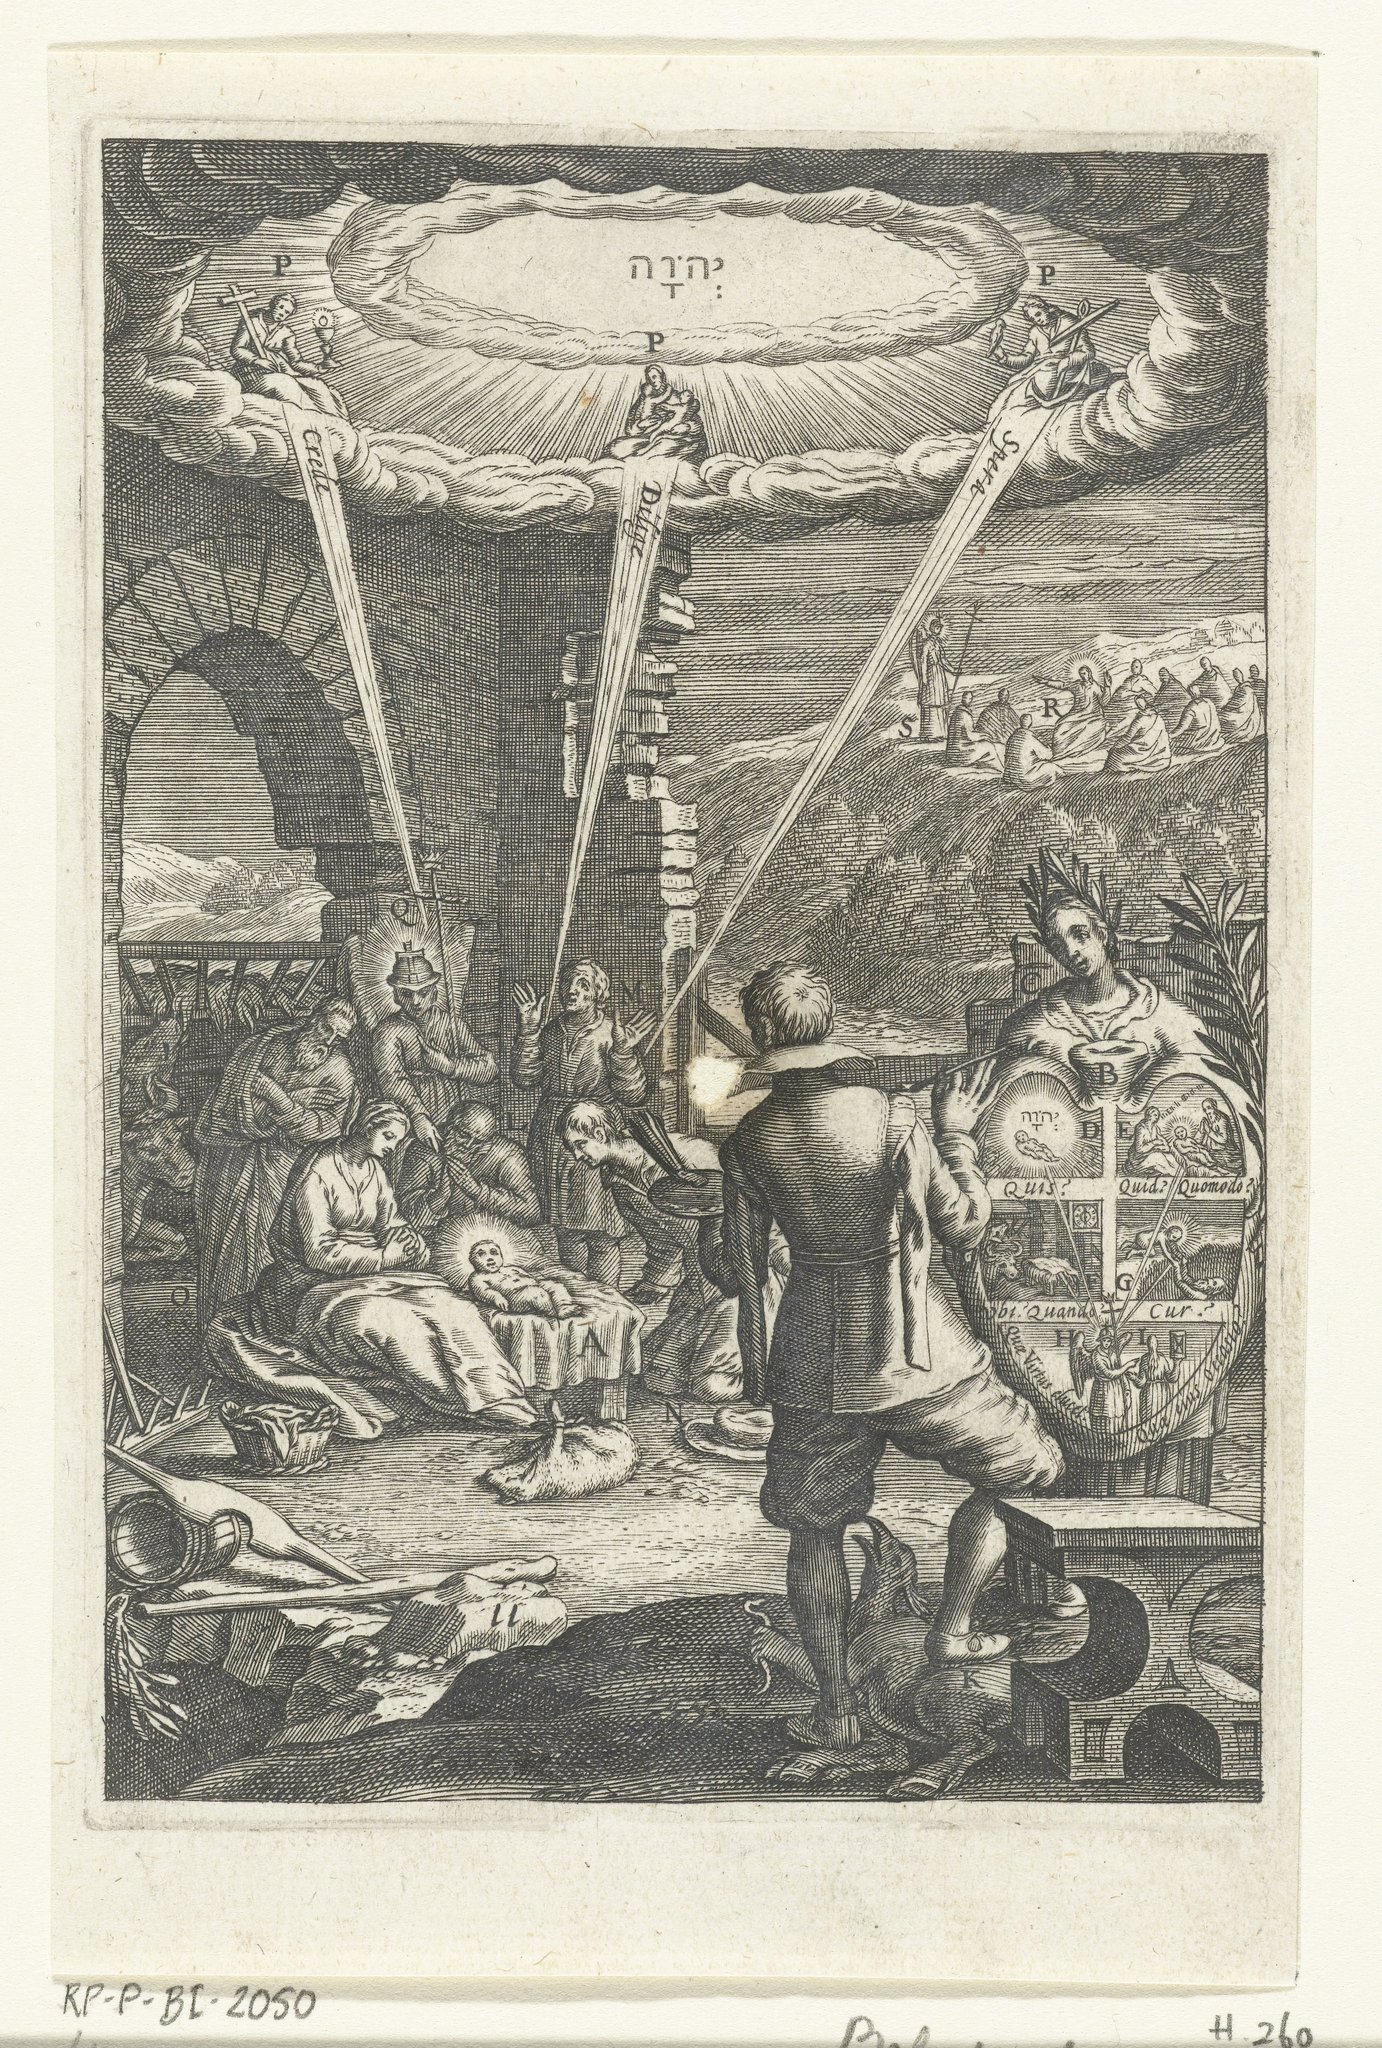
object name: book illustration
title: Embleem met man die mediteert over de geboorte van Christus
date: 1620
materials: paper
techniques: engraving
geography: antwerp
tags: adoration of the christ-child ~ christ's birth, the life of man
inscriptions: collector's mark: Lugt 2228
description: Een man met een schilderspalet observeert een tafereel van de geboorte van Christus. Volgens de begeleidende tekst in de uitgave is deze gebeurtenis een goed uitgangspunt voor meditatie. Men moet zich vooral de deugd van de geboorte voor ogen houden en de daarmee samengaande geloof, hoop en liefde.